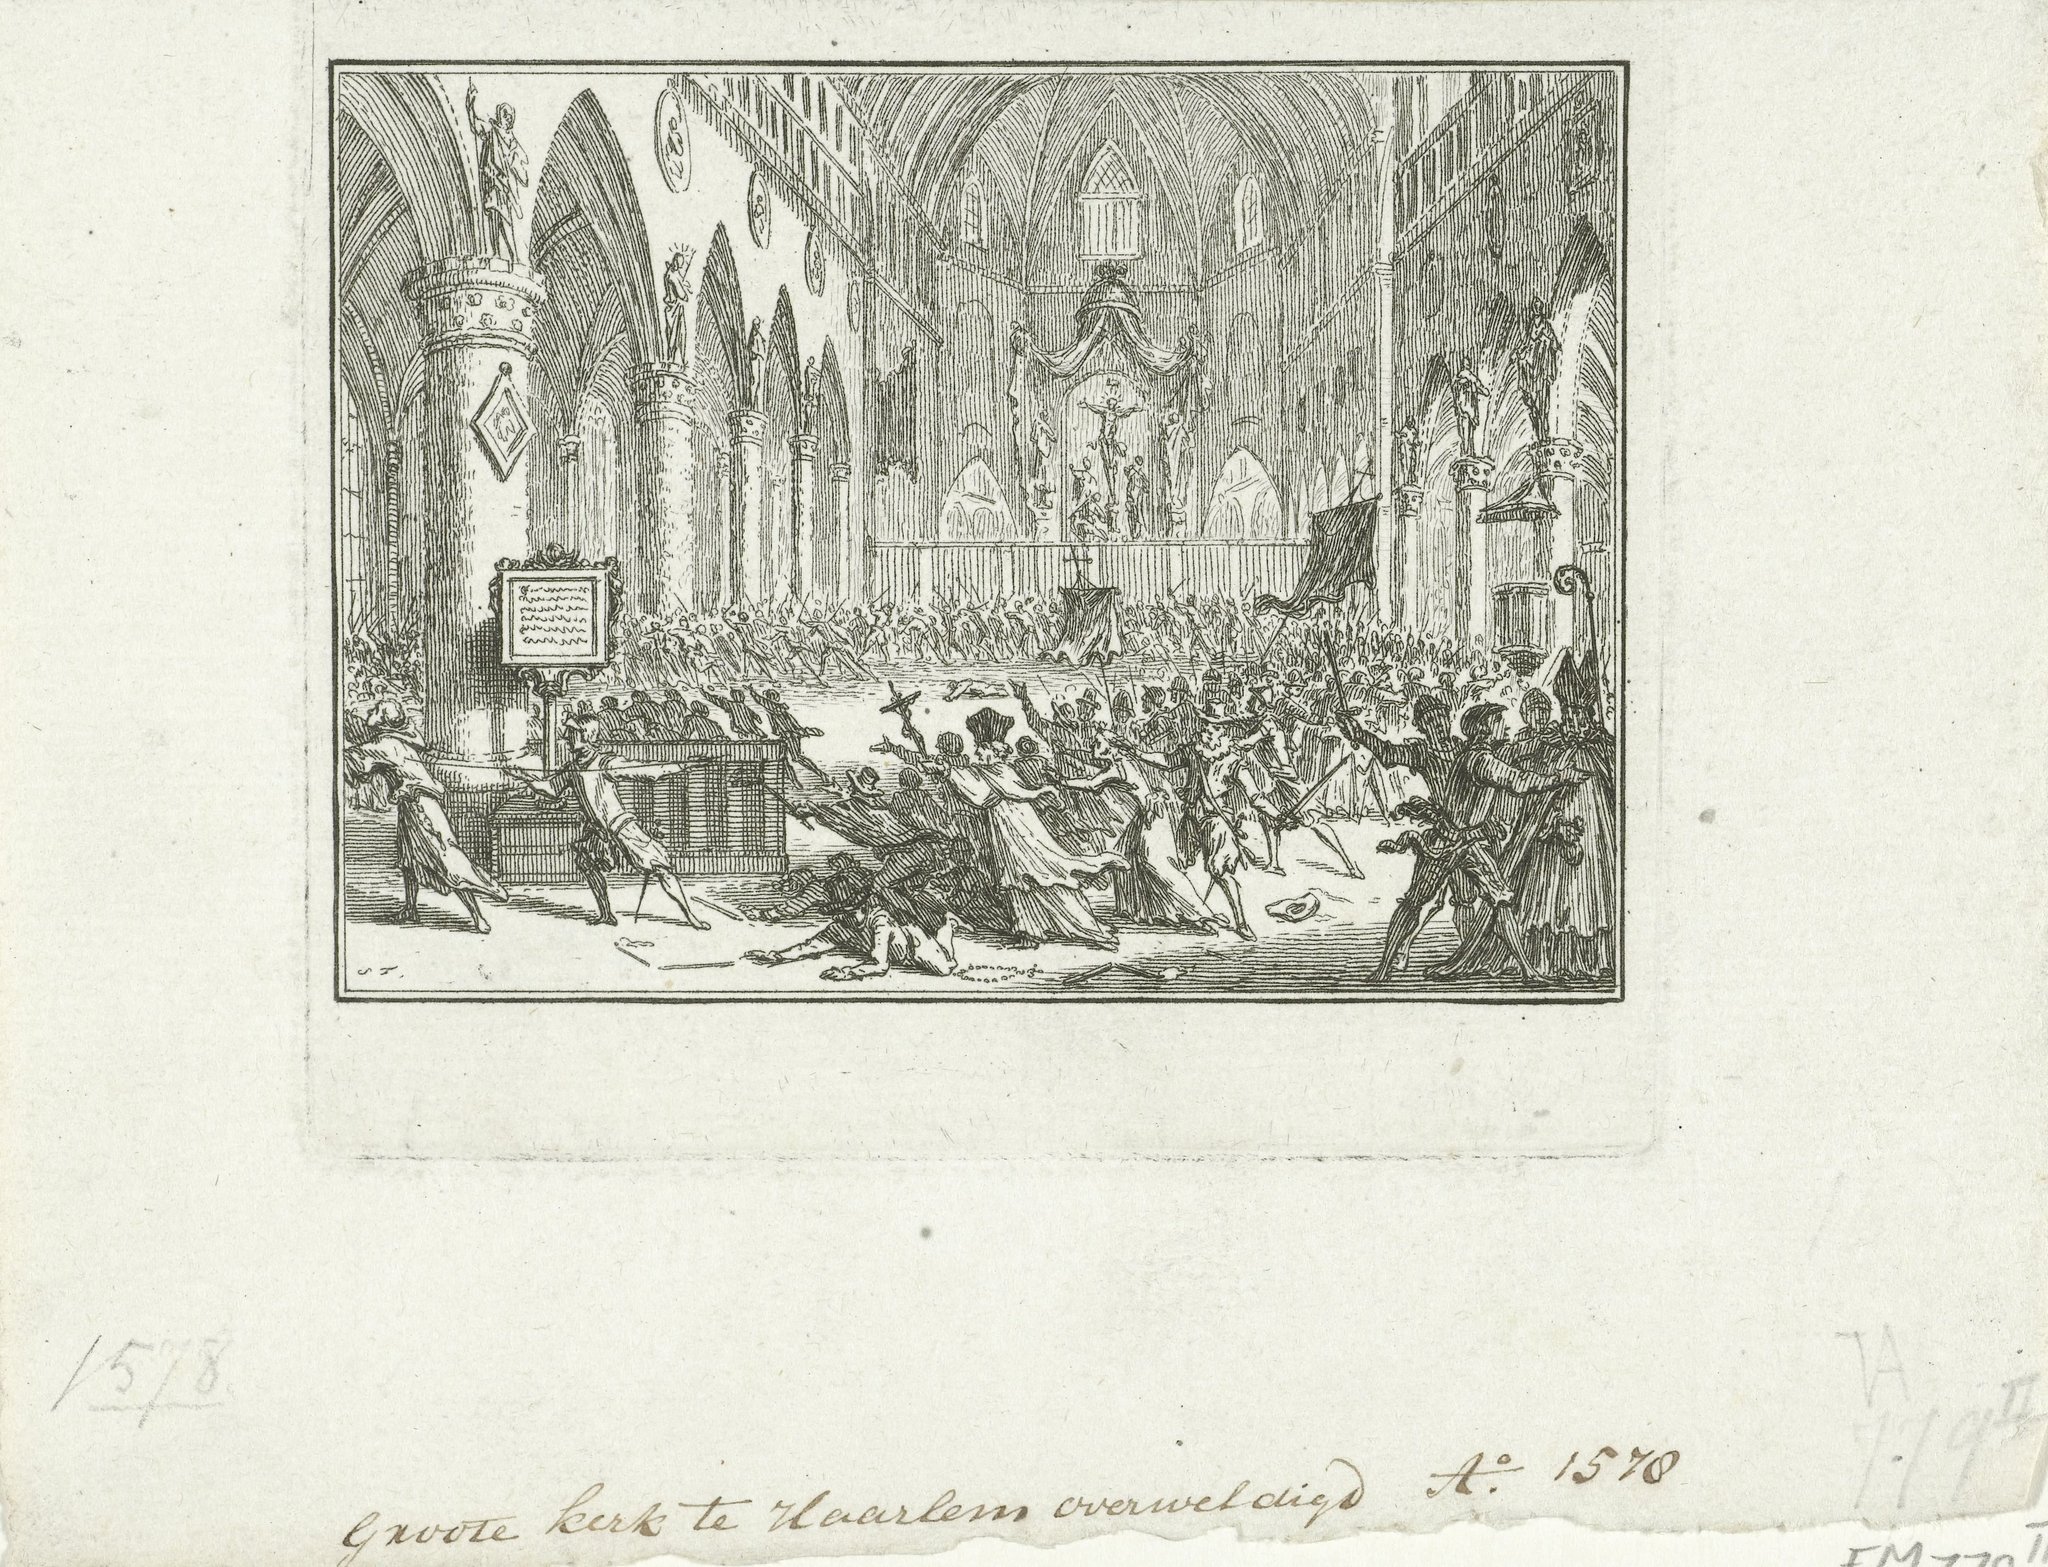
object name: print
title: De Sint-Bavokerk in Haarlem bestormd door protestanten, 1578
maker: simon fokke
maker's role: draughtsman, print maker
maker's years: 1712-1784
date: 1782-1784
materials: paper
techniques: etching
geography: northern netherlands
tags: iconoclasm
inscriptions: inscription: ‘Groote kerk te Haarlem overweldigd Ao. 1578’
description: De Sint-Bavokerk in Haarlem bestormd tijdens het middaggebed (De Noon) door Staatse soldaten en relschoppers, 29 mei 1578. Gezicht in het interieur van de kerk waarin de katholieke geestelijken worden verjaagd en vernielingen worden aangericht, hierbij wordt de priester Balling vermoord. Deze gebeurtenis staat bekend als De Haarlemse Noon.